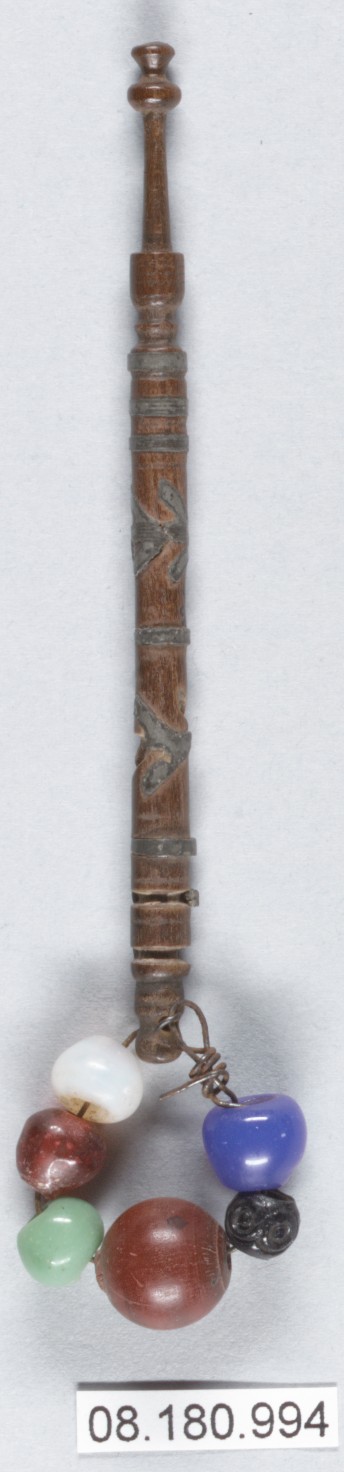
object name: bobbin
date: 1801-1900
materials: metal, wood